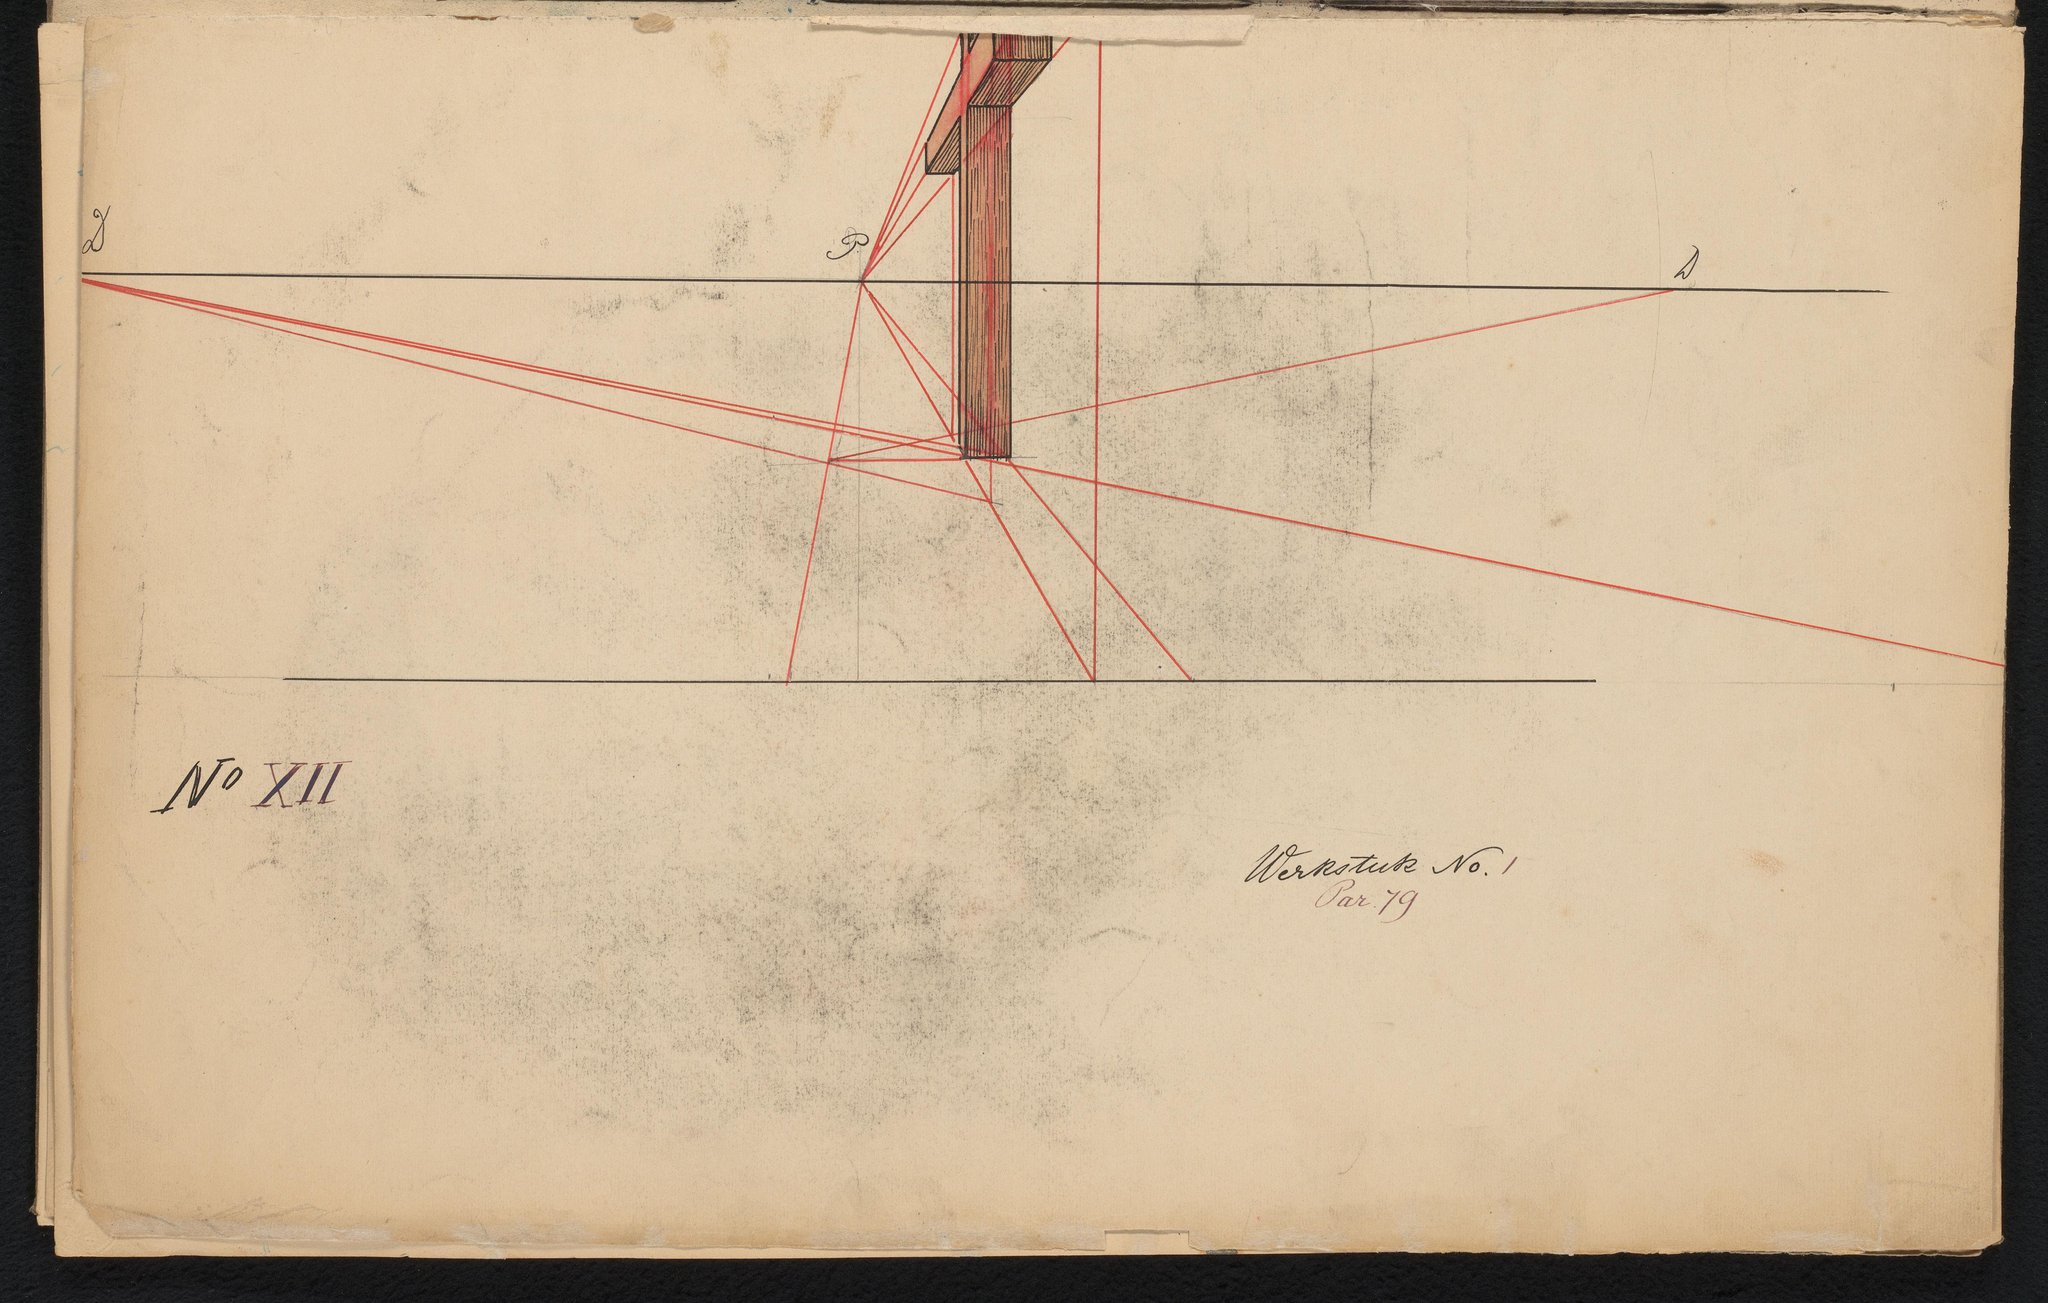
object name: sketchbook leaf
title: Houten kruis in mathematisch perspectief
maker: huib luns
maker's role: draughtsman, print maker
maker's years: 1881-1942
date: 1908-1909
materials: ink, paper, pencil, watercolor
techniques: brush, pen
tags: the cross ~ symbols of christ, mathematical perspective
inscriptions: annotation: ‘P/ D/ No XII Werkstuk No. 1/ Par. 79’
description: Blad 20 recto uit een schetsboek met 24 bladen.